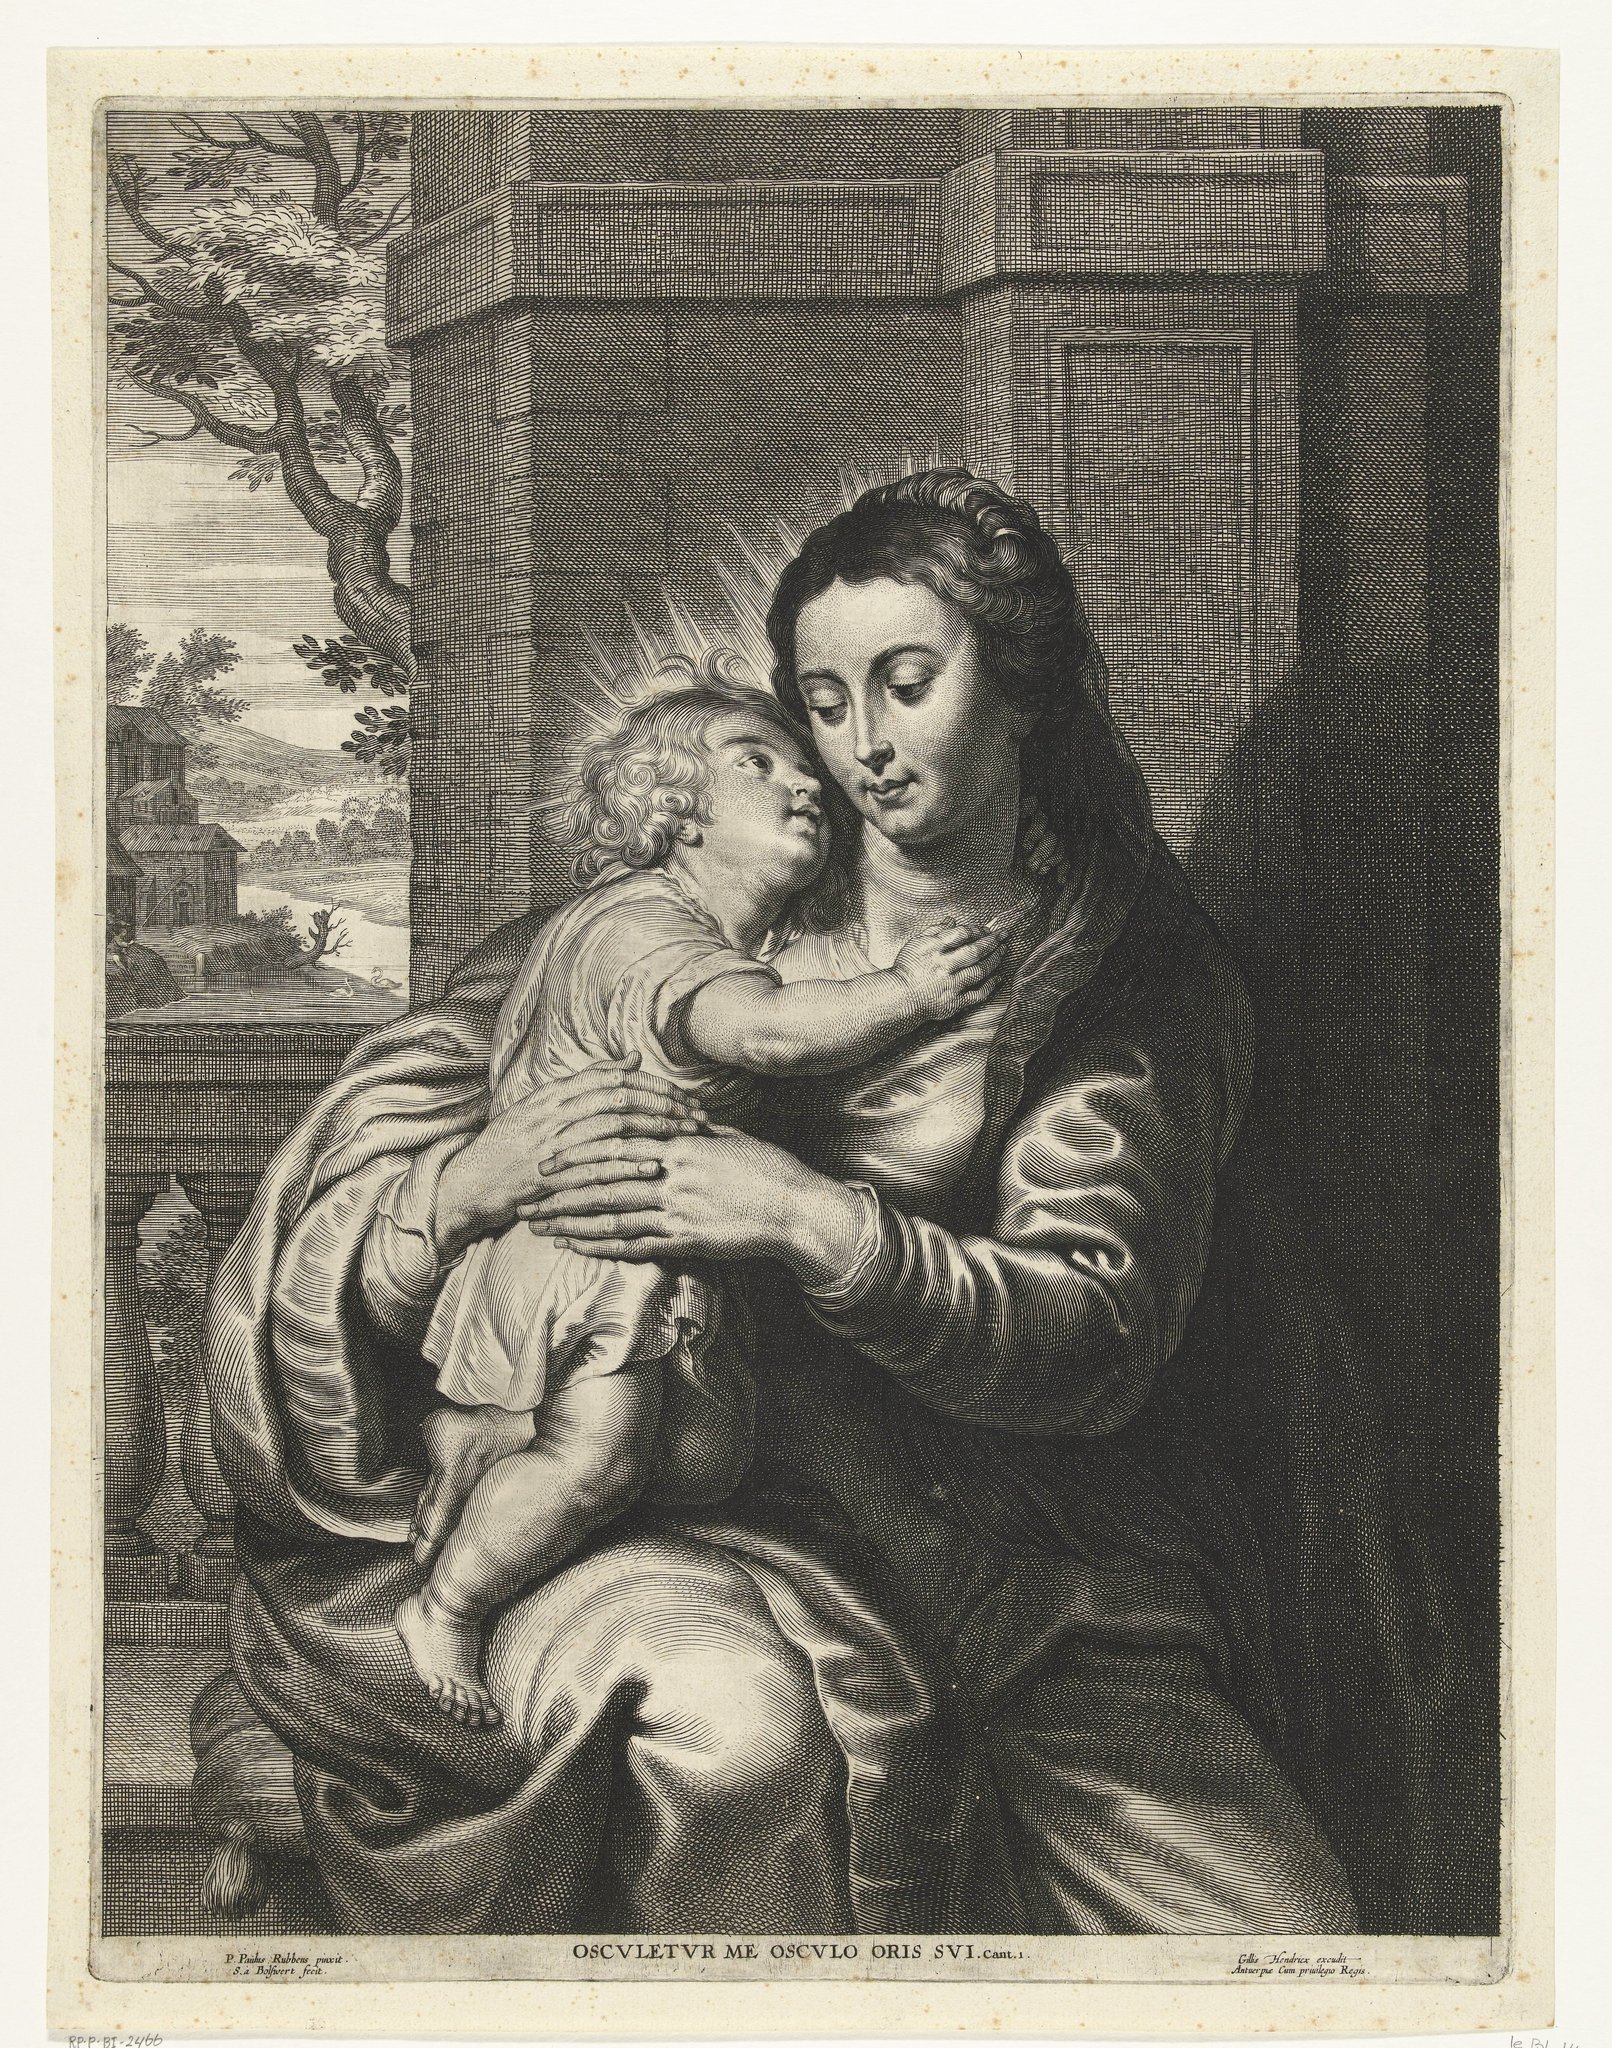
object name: print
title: Maria met kind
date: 1596-1659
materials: paper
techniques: engraving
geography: antwerp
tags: christ-child throwing his arm(s) around her neck ~ madonna-representations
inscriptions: collector's mark: Lugt 240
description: Maria zit met in haar armen het Christuskind dat haar omhelst. Onder de voorstelling staat een citaat uit de bijbeltekst Spreuken 1.